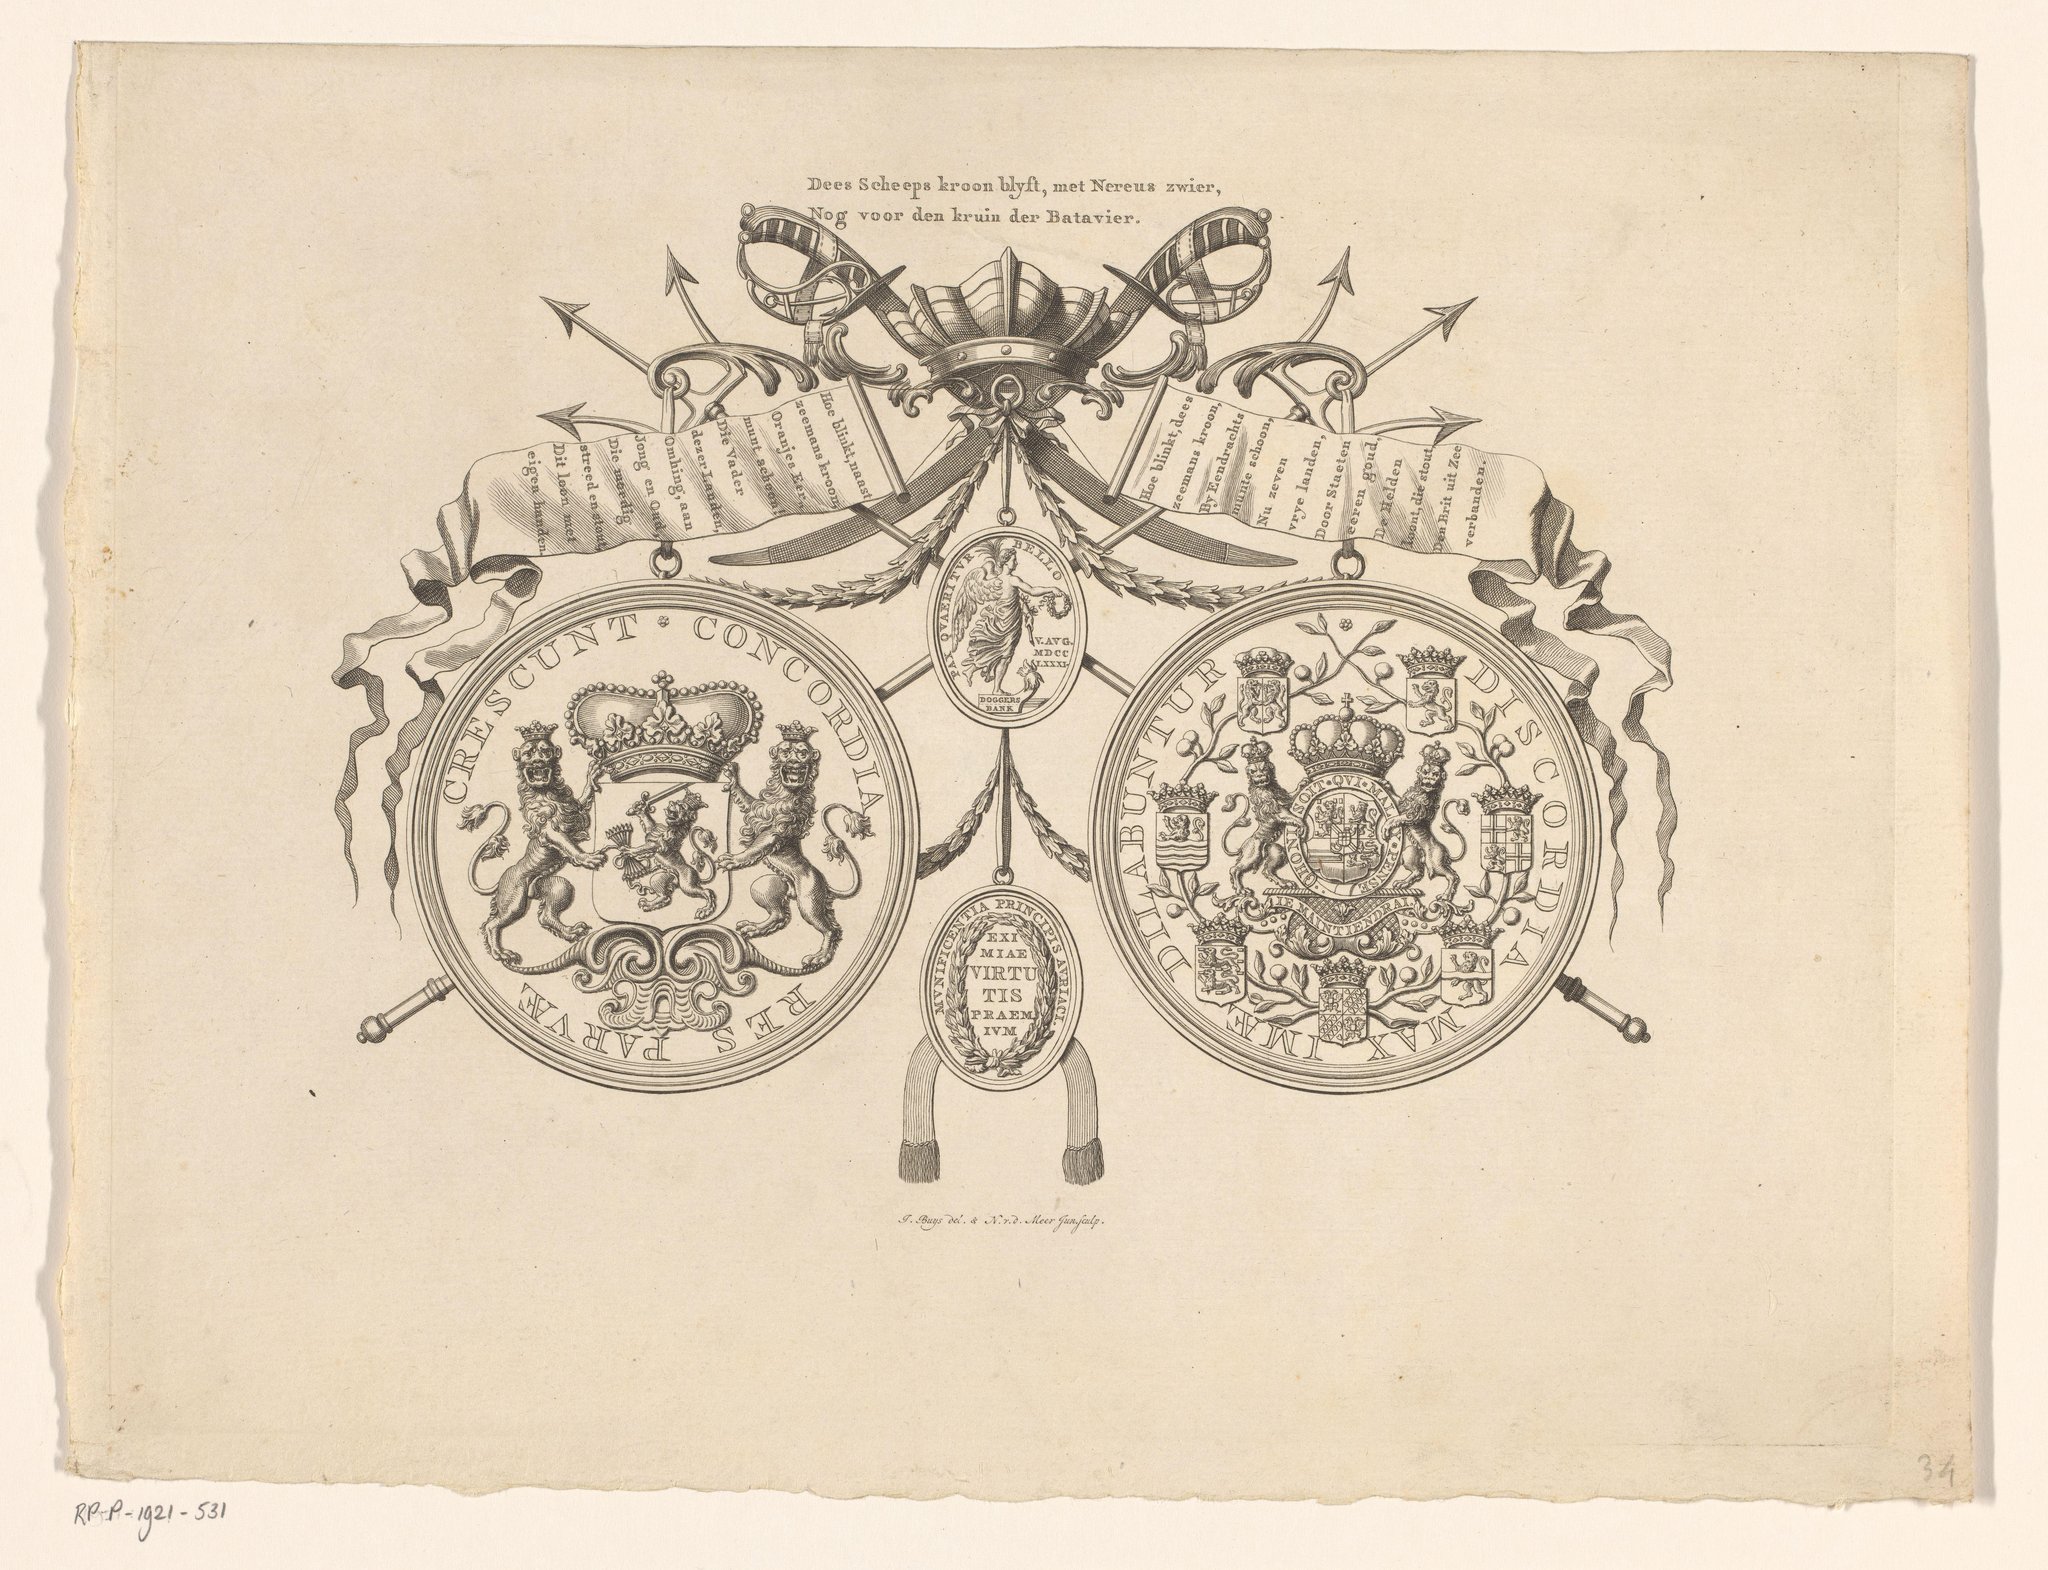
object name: print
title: Gedenkpenning voor de slag bij de Doggersbank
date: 1781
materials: paper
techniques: etching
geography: amsterdam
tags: medals and other marks of military honour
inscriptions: collector's mark: Lugt 2233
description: De voor- en achterzijde van een gedenkpenning, ter herinnering aan de zeeslag bij de Doggersbank in 1781, met de wapenschilden van de Republiek der Zeven Verenigde Nederlanden en het motto: De kleinen groeien door eendracht, de grootsten gaan ten onder door tweedracht. Midden boven twee drietanden, degens en wimpels.